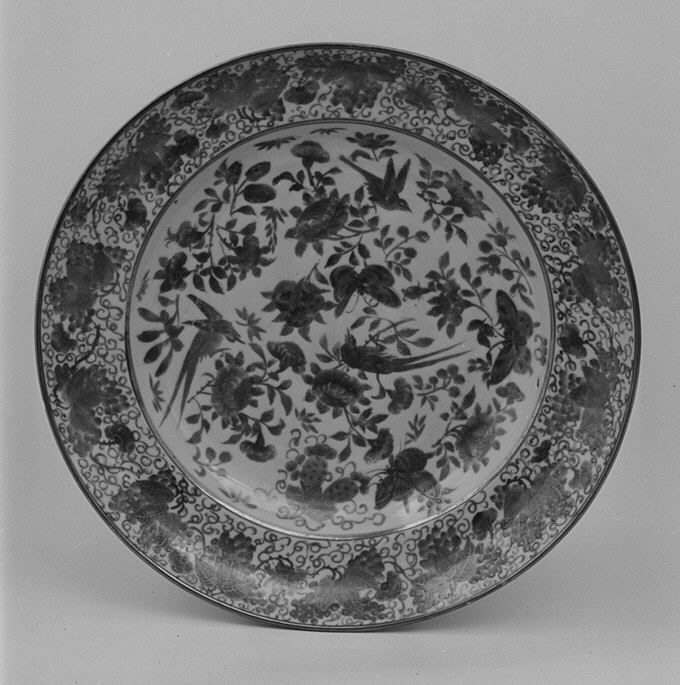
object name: soup plate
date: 1801-1833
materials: hard paste porcelain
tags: birds,butterflies,flowers